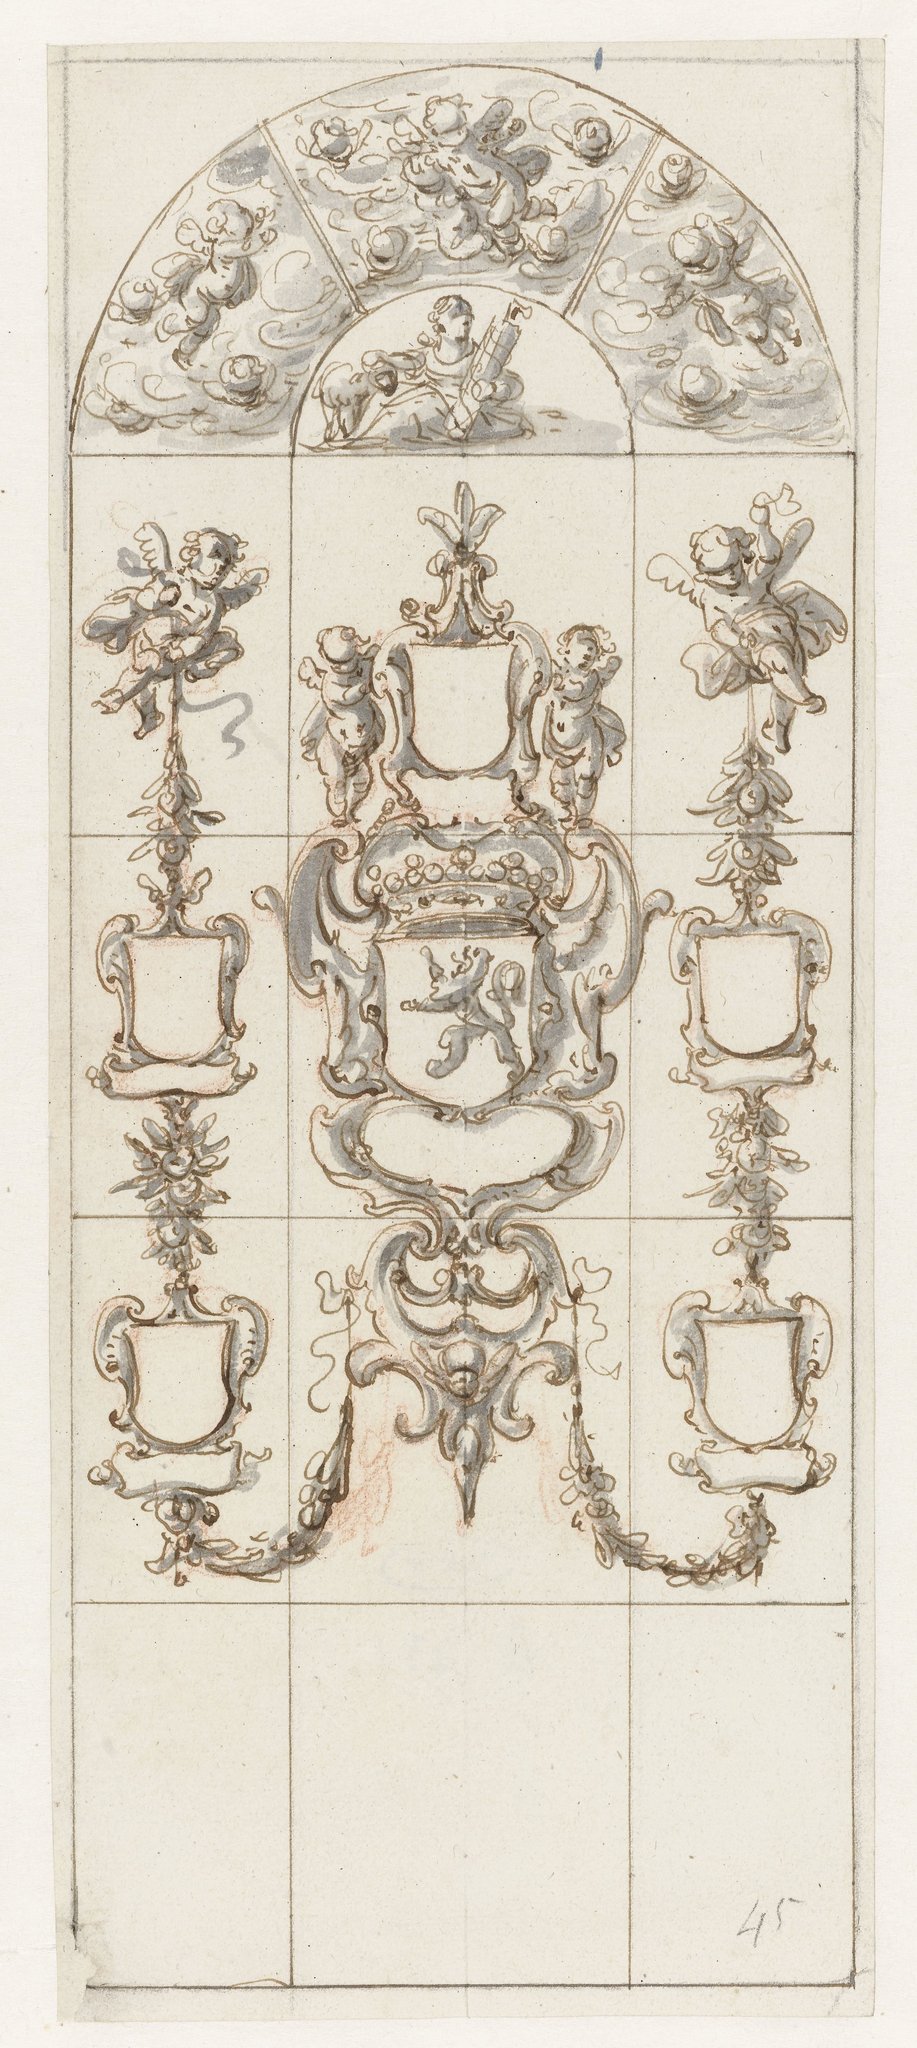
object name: drawing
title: Ontwerp voor een glasraam met blanco wapenschilden en putti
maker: pieter jansz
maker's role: draughtsman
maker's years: 1602-1672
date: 1630-1672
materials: chalk, ink, paper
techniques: brush, pen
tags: fortitude, 'fortitudo' ~ one of the four cardinal virtues, cupids: 'amores', 'amoretti', 'putti', coat of arms (as symbol of the state, etc.) (+ province; provincial)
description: Ontwerp voor een glasraam met in het midden een wapenschild met een klimmende leeuw, geflankeerd door twee putti met elk twee blanco wapenschilden. Bovenaan een allegorische figuur, voorstellende een vrouw met een pijlenbundel en een schaap, omringd door putti.